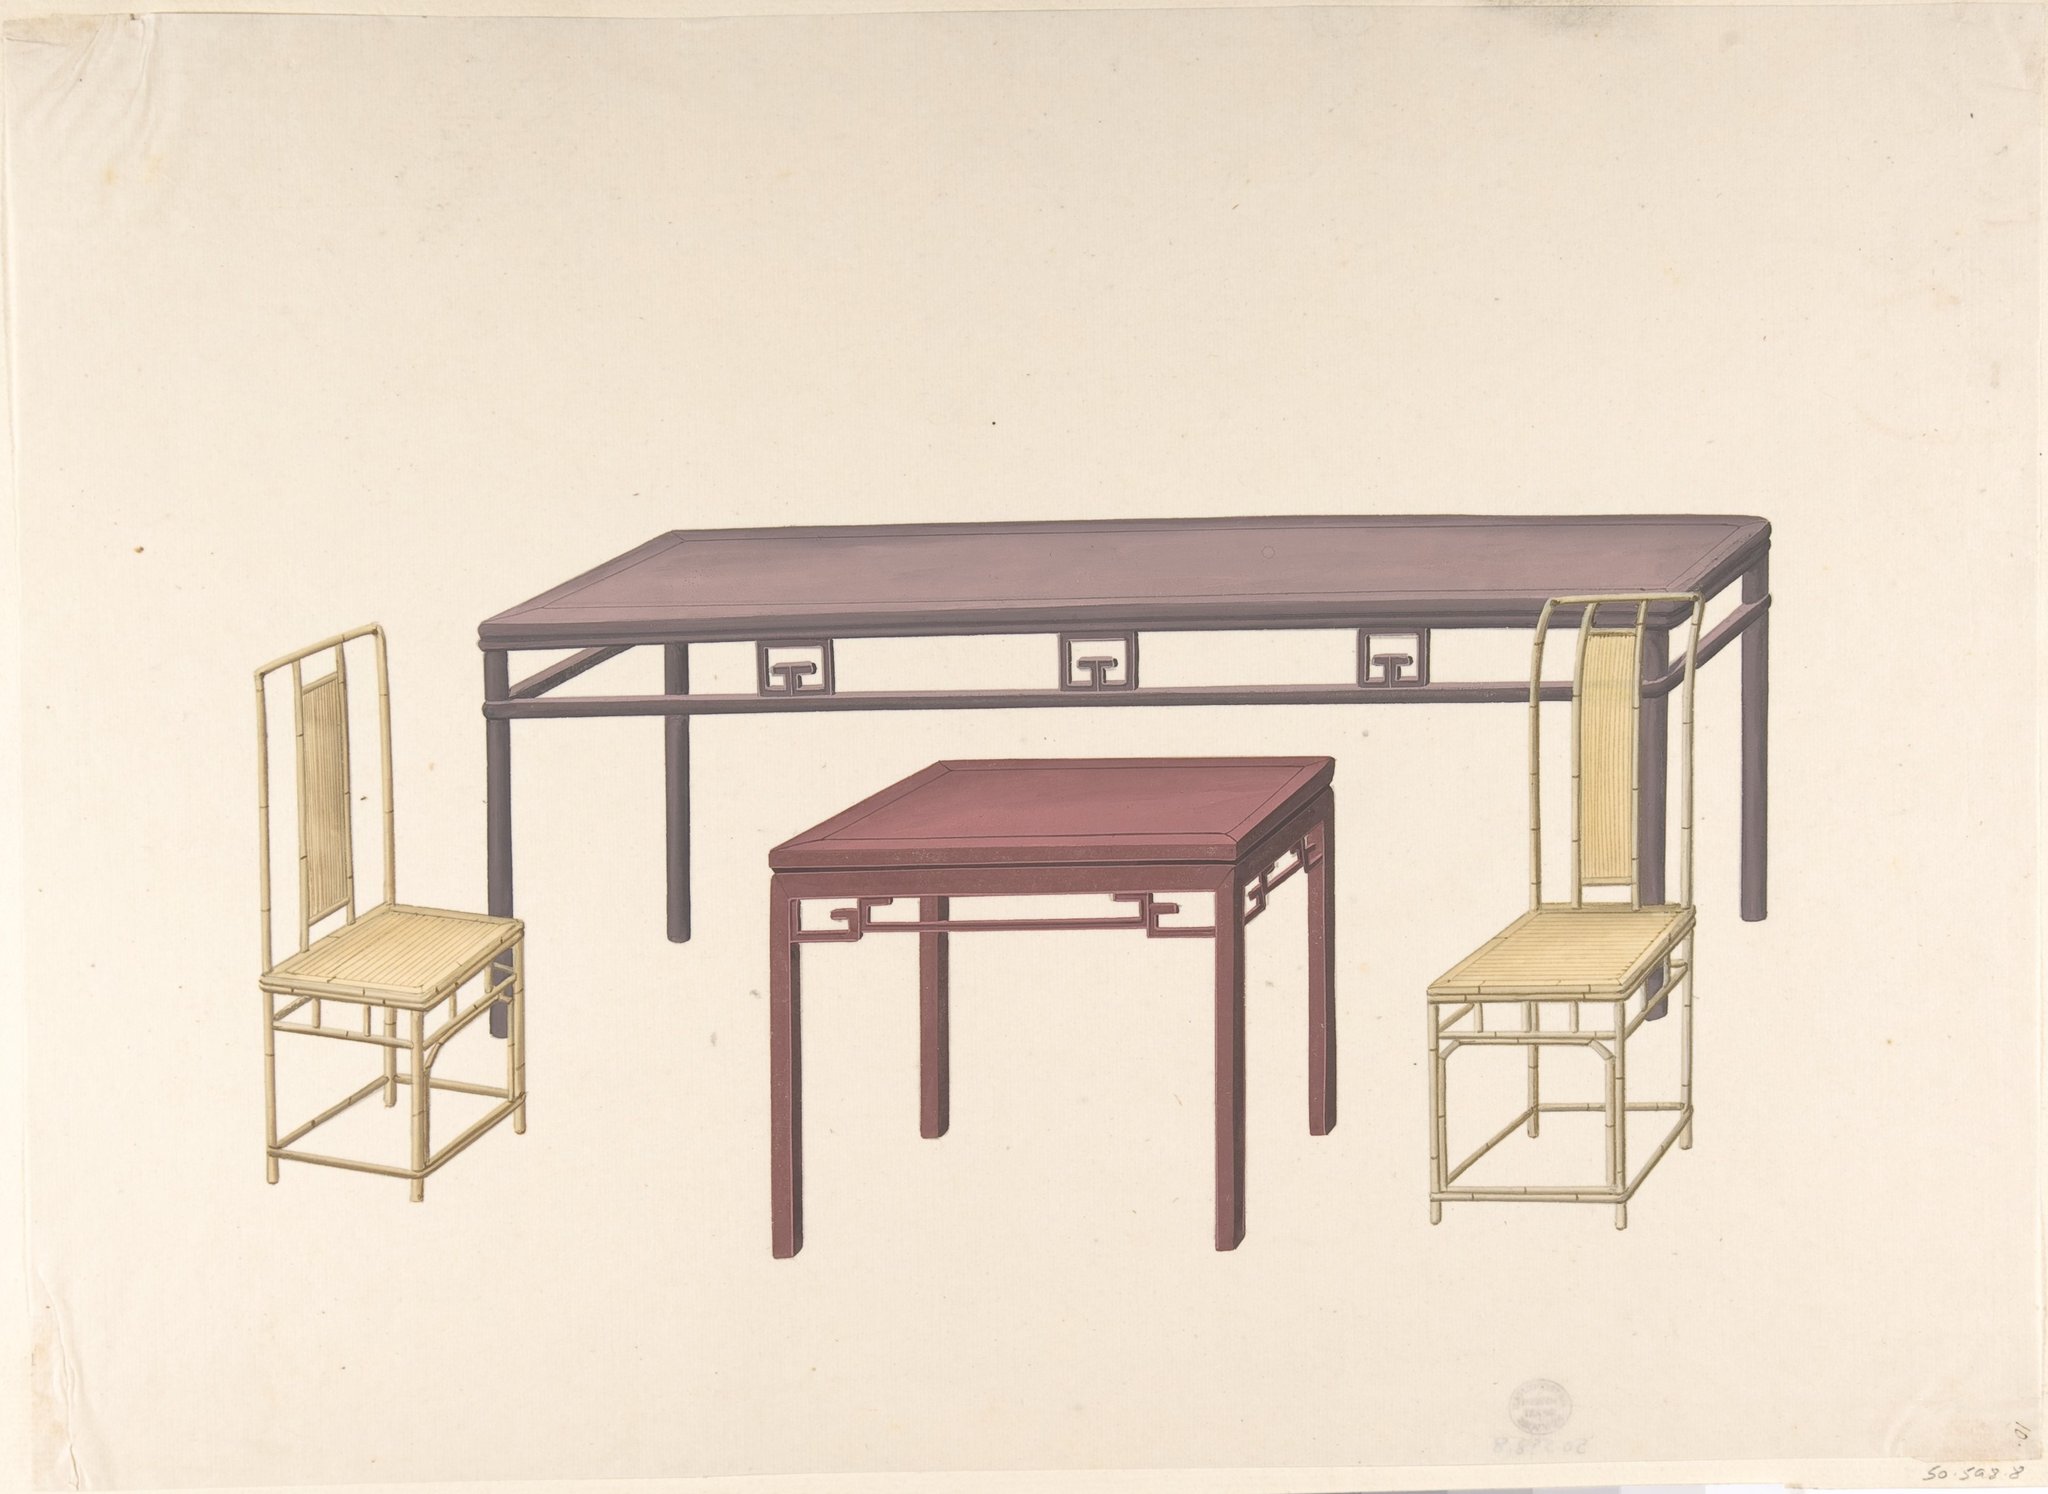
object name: drawing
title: Design for Export Furniture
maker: anonymous, chinese, 19th century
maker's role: artist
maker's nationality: chinese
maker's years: 1800-1900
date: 1800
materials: graphite, watercolor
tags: furniture